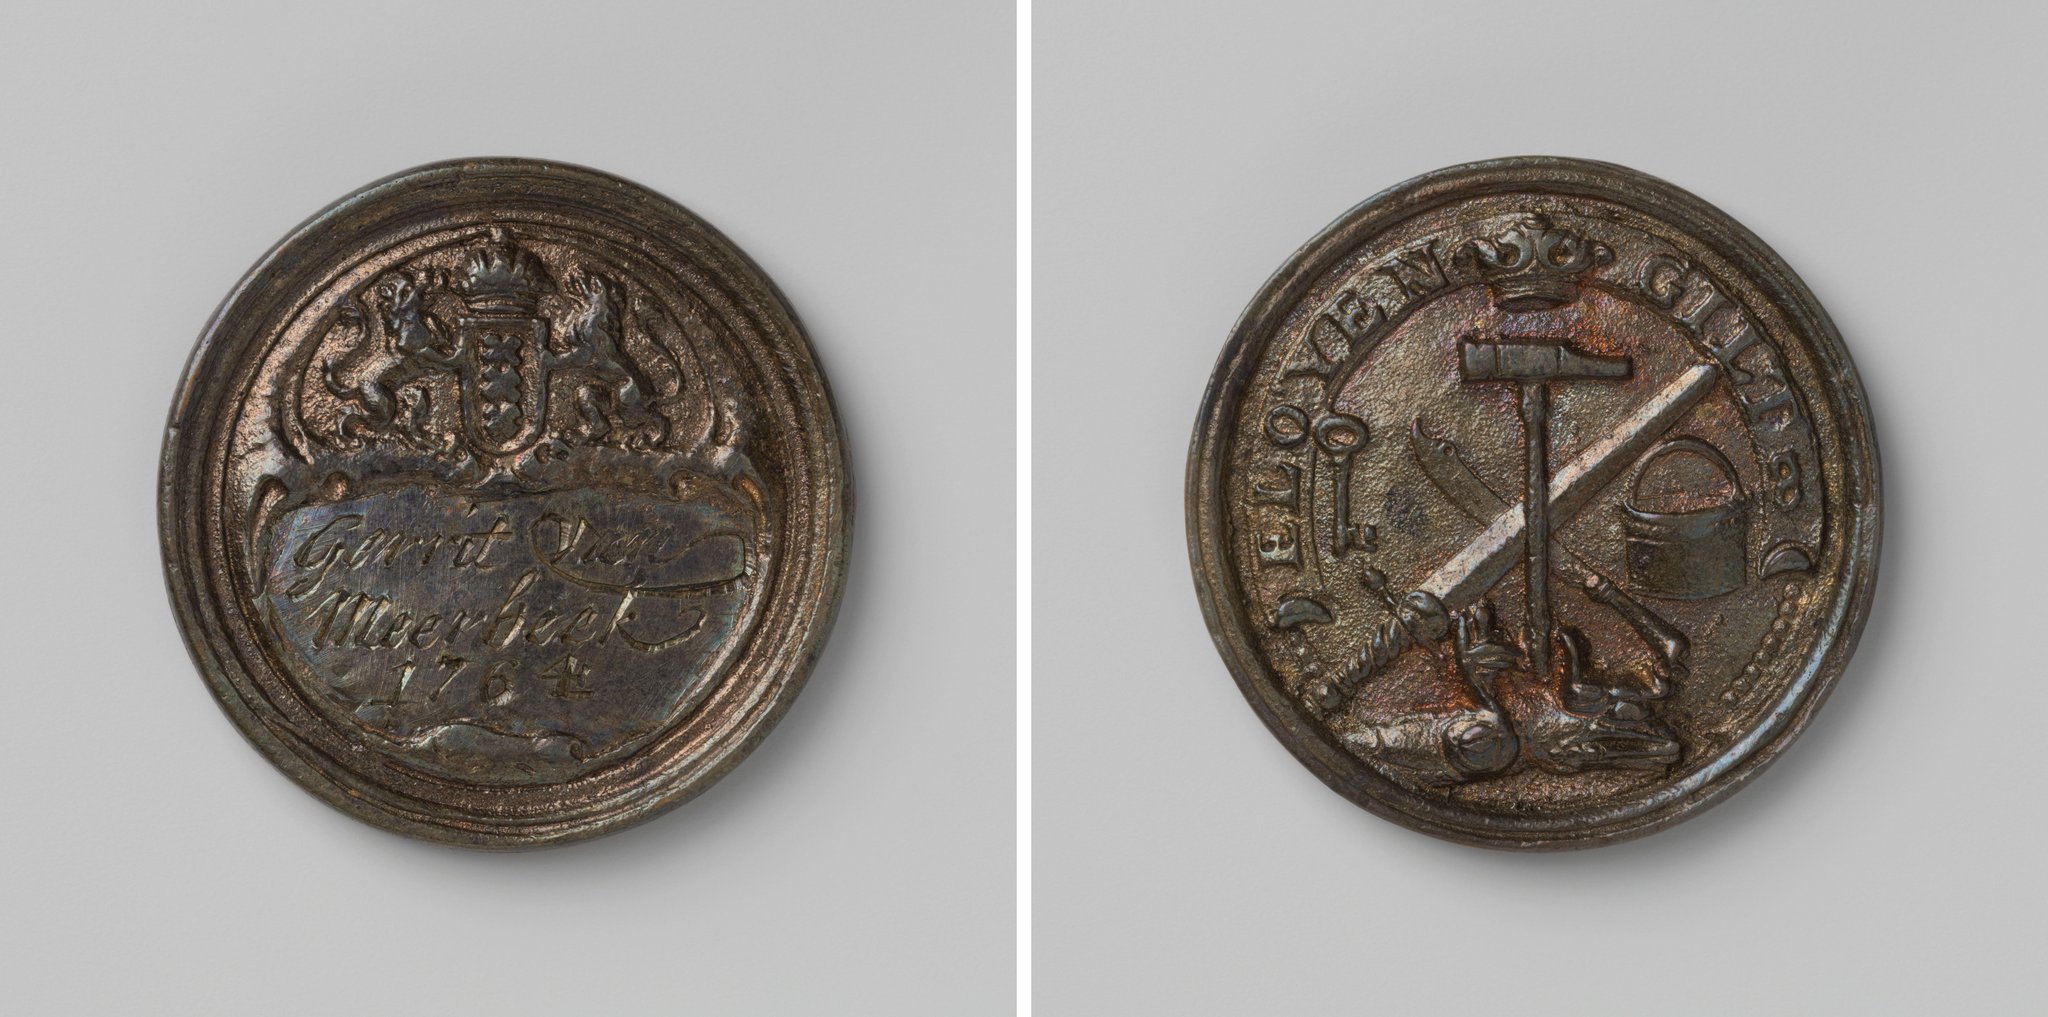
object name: medal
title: Gildepenning van het Smedengilde Sint Eloy te Amsterdam, op naam van Gerrit van Meerbeek.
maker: Anonymous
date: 1764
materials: brass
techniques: casting, engraving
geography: amsterdam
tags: goldsmith, amsterdam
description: Guilds were urban organisations of people in specific occupations. The guild represented the interests of the profession. Each member had a token as proof of membership. The person’s name was engraved on one side of the token, often together with the arms of the guild or of the city in which it was based. The other side carried a motif signifying the occupation represented by the guild.